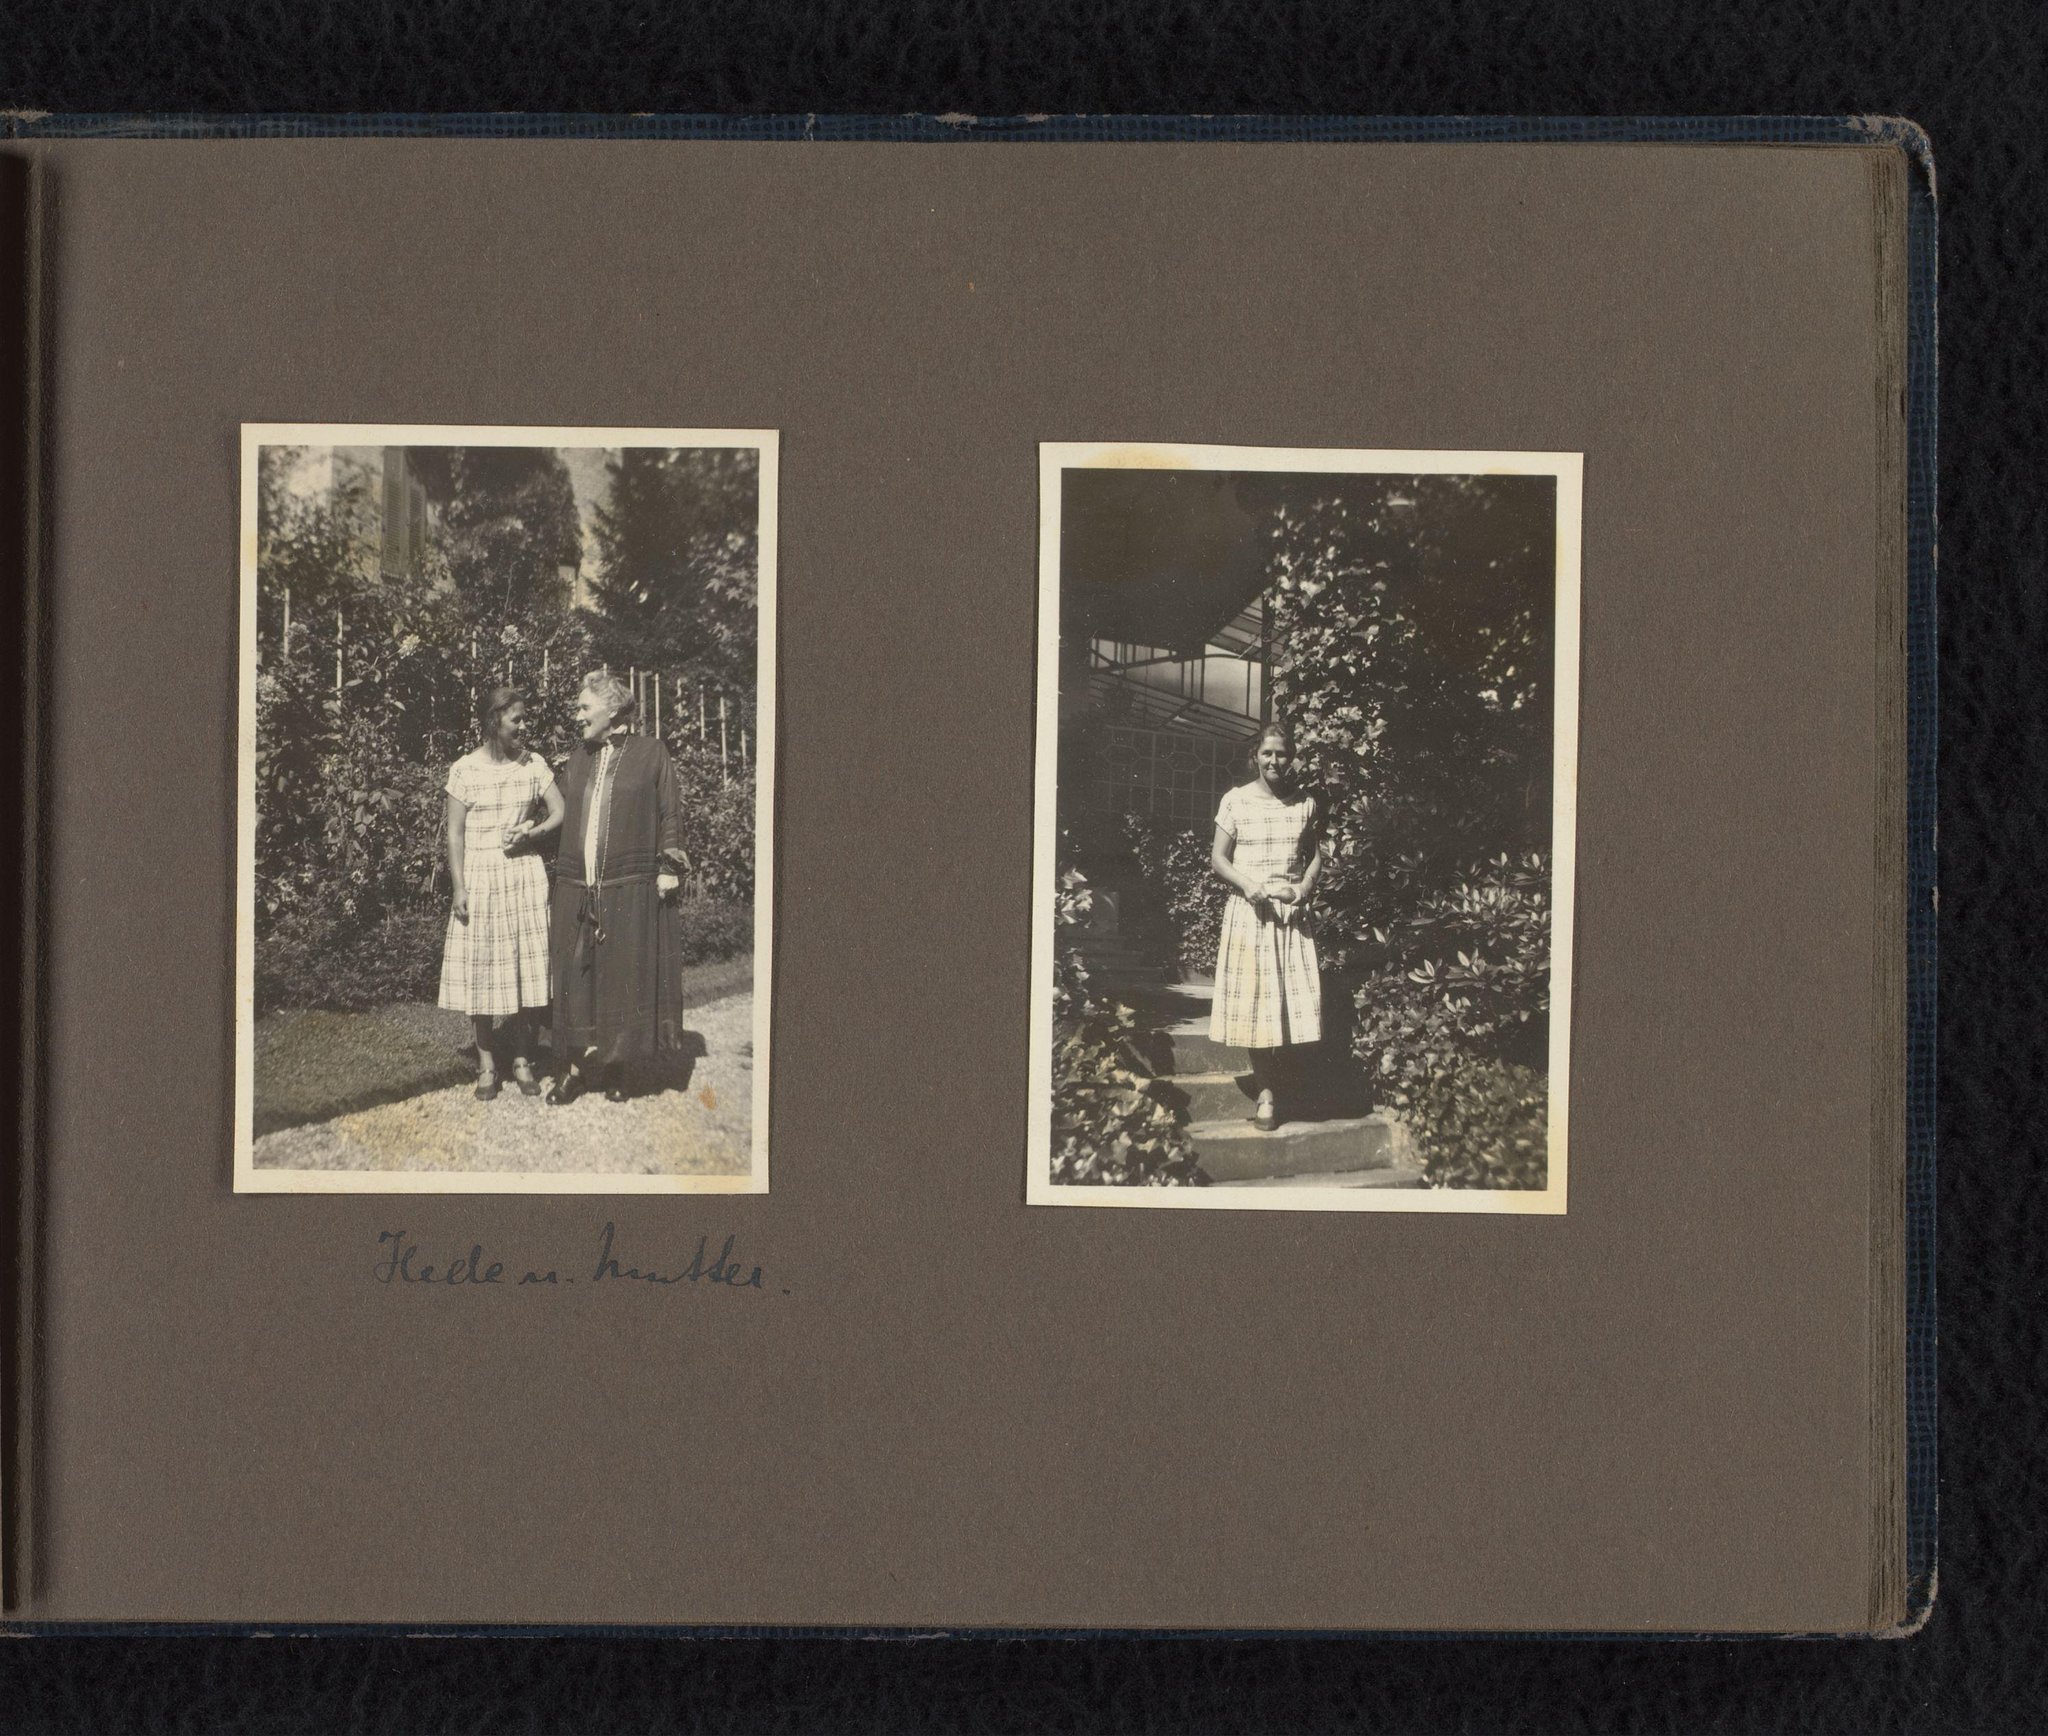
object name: photograph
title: Hede in de tuin met een vrouw die is aangeduid als Mutter (moeder), mogelijk Josefine Moos-Levi of Mathilde Wachenheimer-Wertheimer op latere leeftijd, vermoedelijk 1928, Stuttgart of Hamburg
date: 1928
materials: paper, photographic support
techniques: gelatin silver print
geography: germany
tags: josefine moos-levi, family life at home, germany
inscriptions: inscription: ‘Hede u. Mutter.’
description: Albumblad bevat twee foto's van Hede (jonge vrouw) en oudere vrouw (mogelijk Josefine Moos-Levi). Uit album half formaat, blauw kunstlederen omslag met koordbinding.